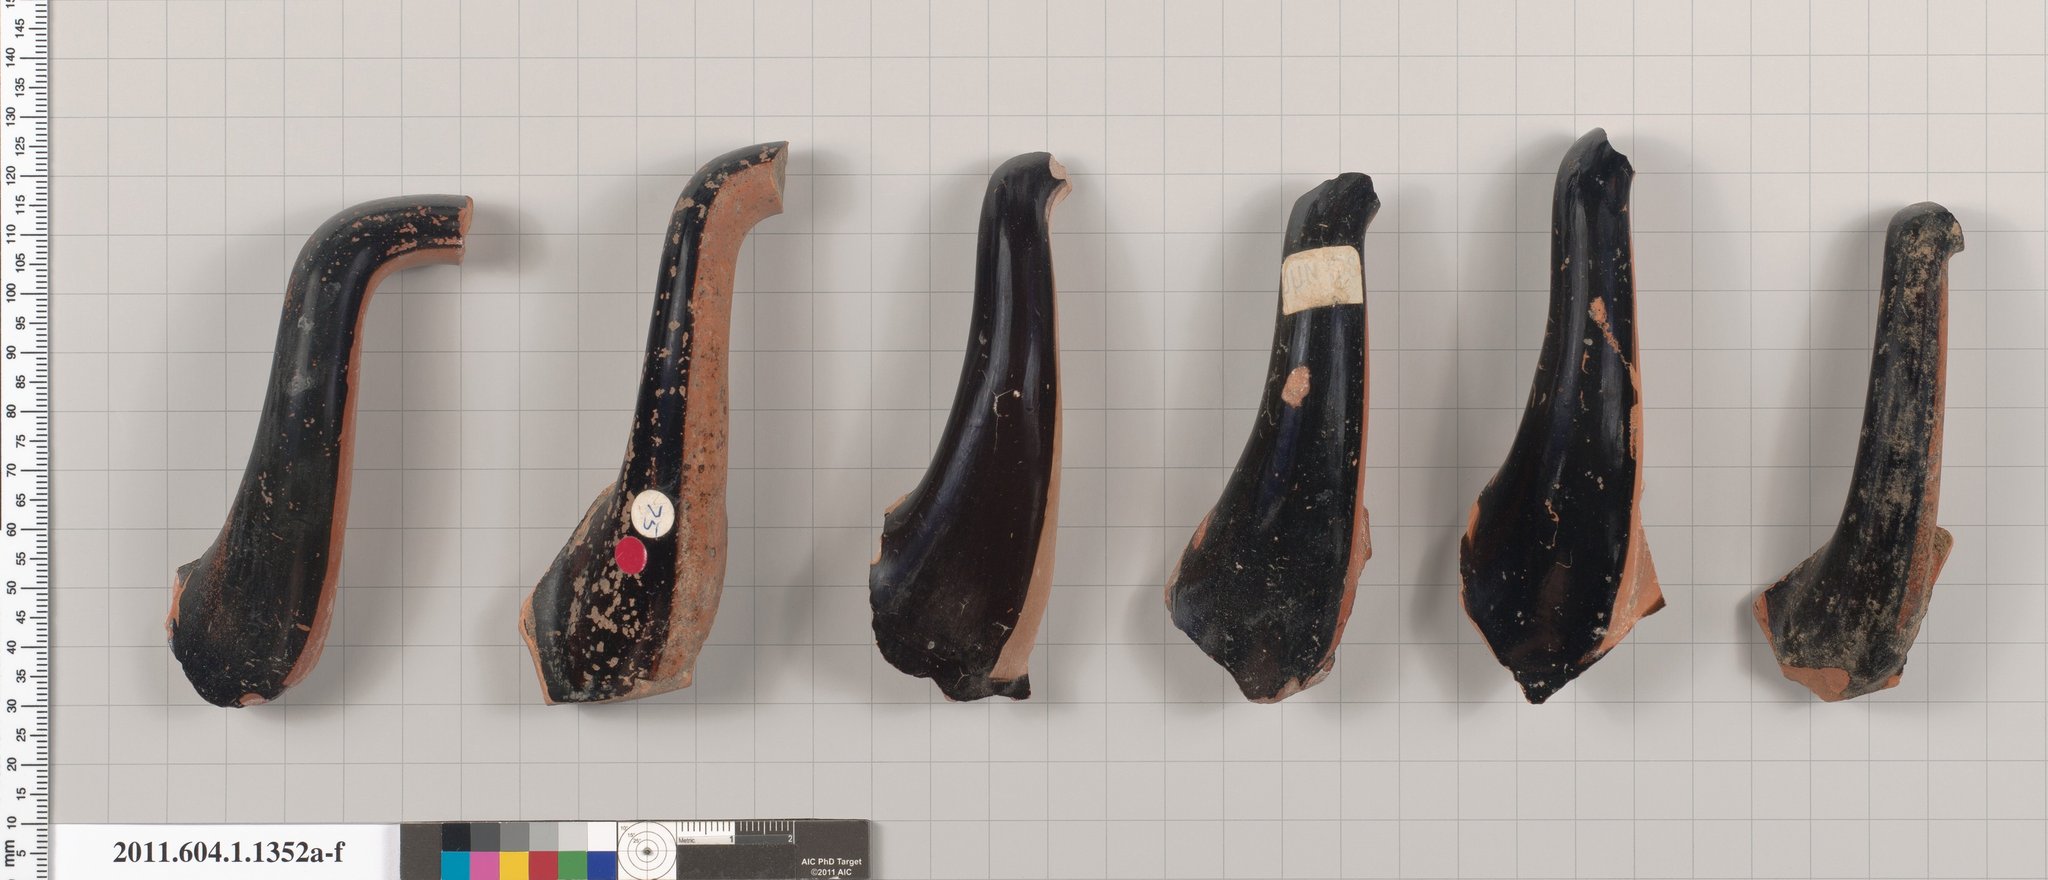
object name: kylix fragment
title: Terracotta fragments of kylikes (drinking cups)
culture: greek, attic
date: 500-401 BCE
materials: terracotta